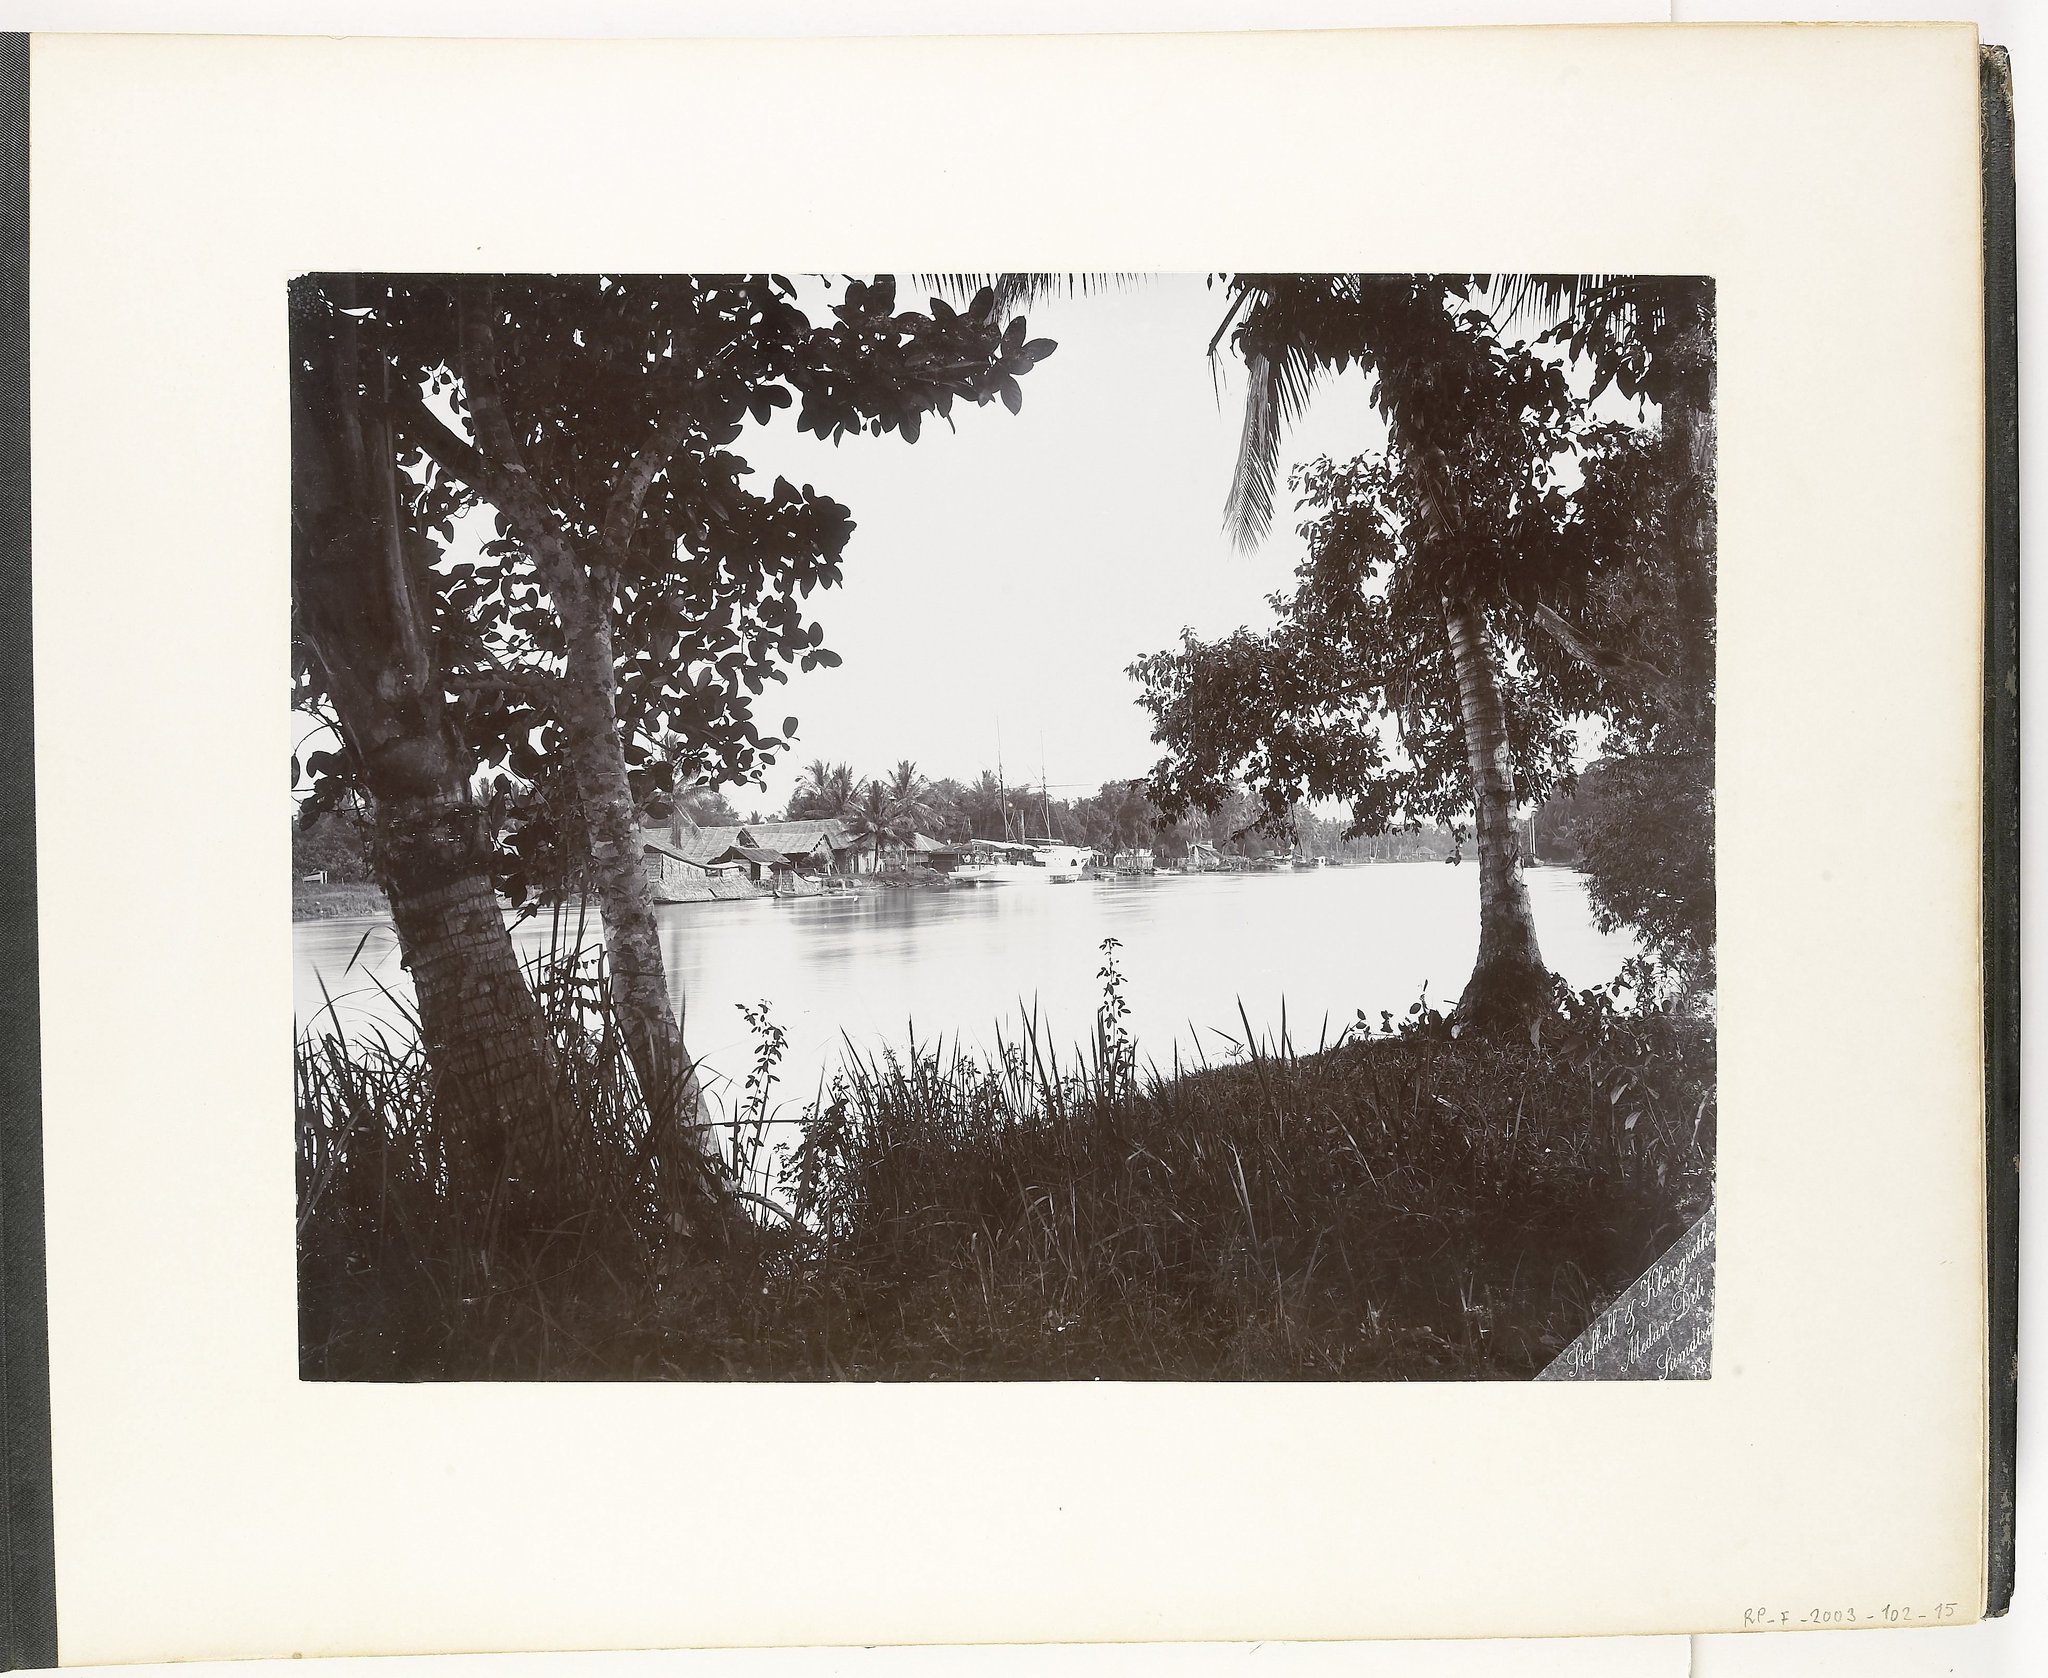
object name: photograph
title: Gezicht op de haven Tandjong Poera, Sumatra (Blick auf Tandjong Poera)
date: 1890-1900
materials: photographic support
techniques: collodion silver print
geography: tandjong poera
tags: tandjong poera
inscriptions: number: ‘Sumatra 28’, signature: ‘Stafhell & Kleingrothe Medan- Deli’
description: Gezicht op de haven van Tandjoengpoera (Tandjong Poera) op de Oostkust van Sumatra. Onderdeel van het Sumatra fotoalbum van Paul en Lucie Sandel uit 1900.